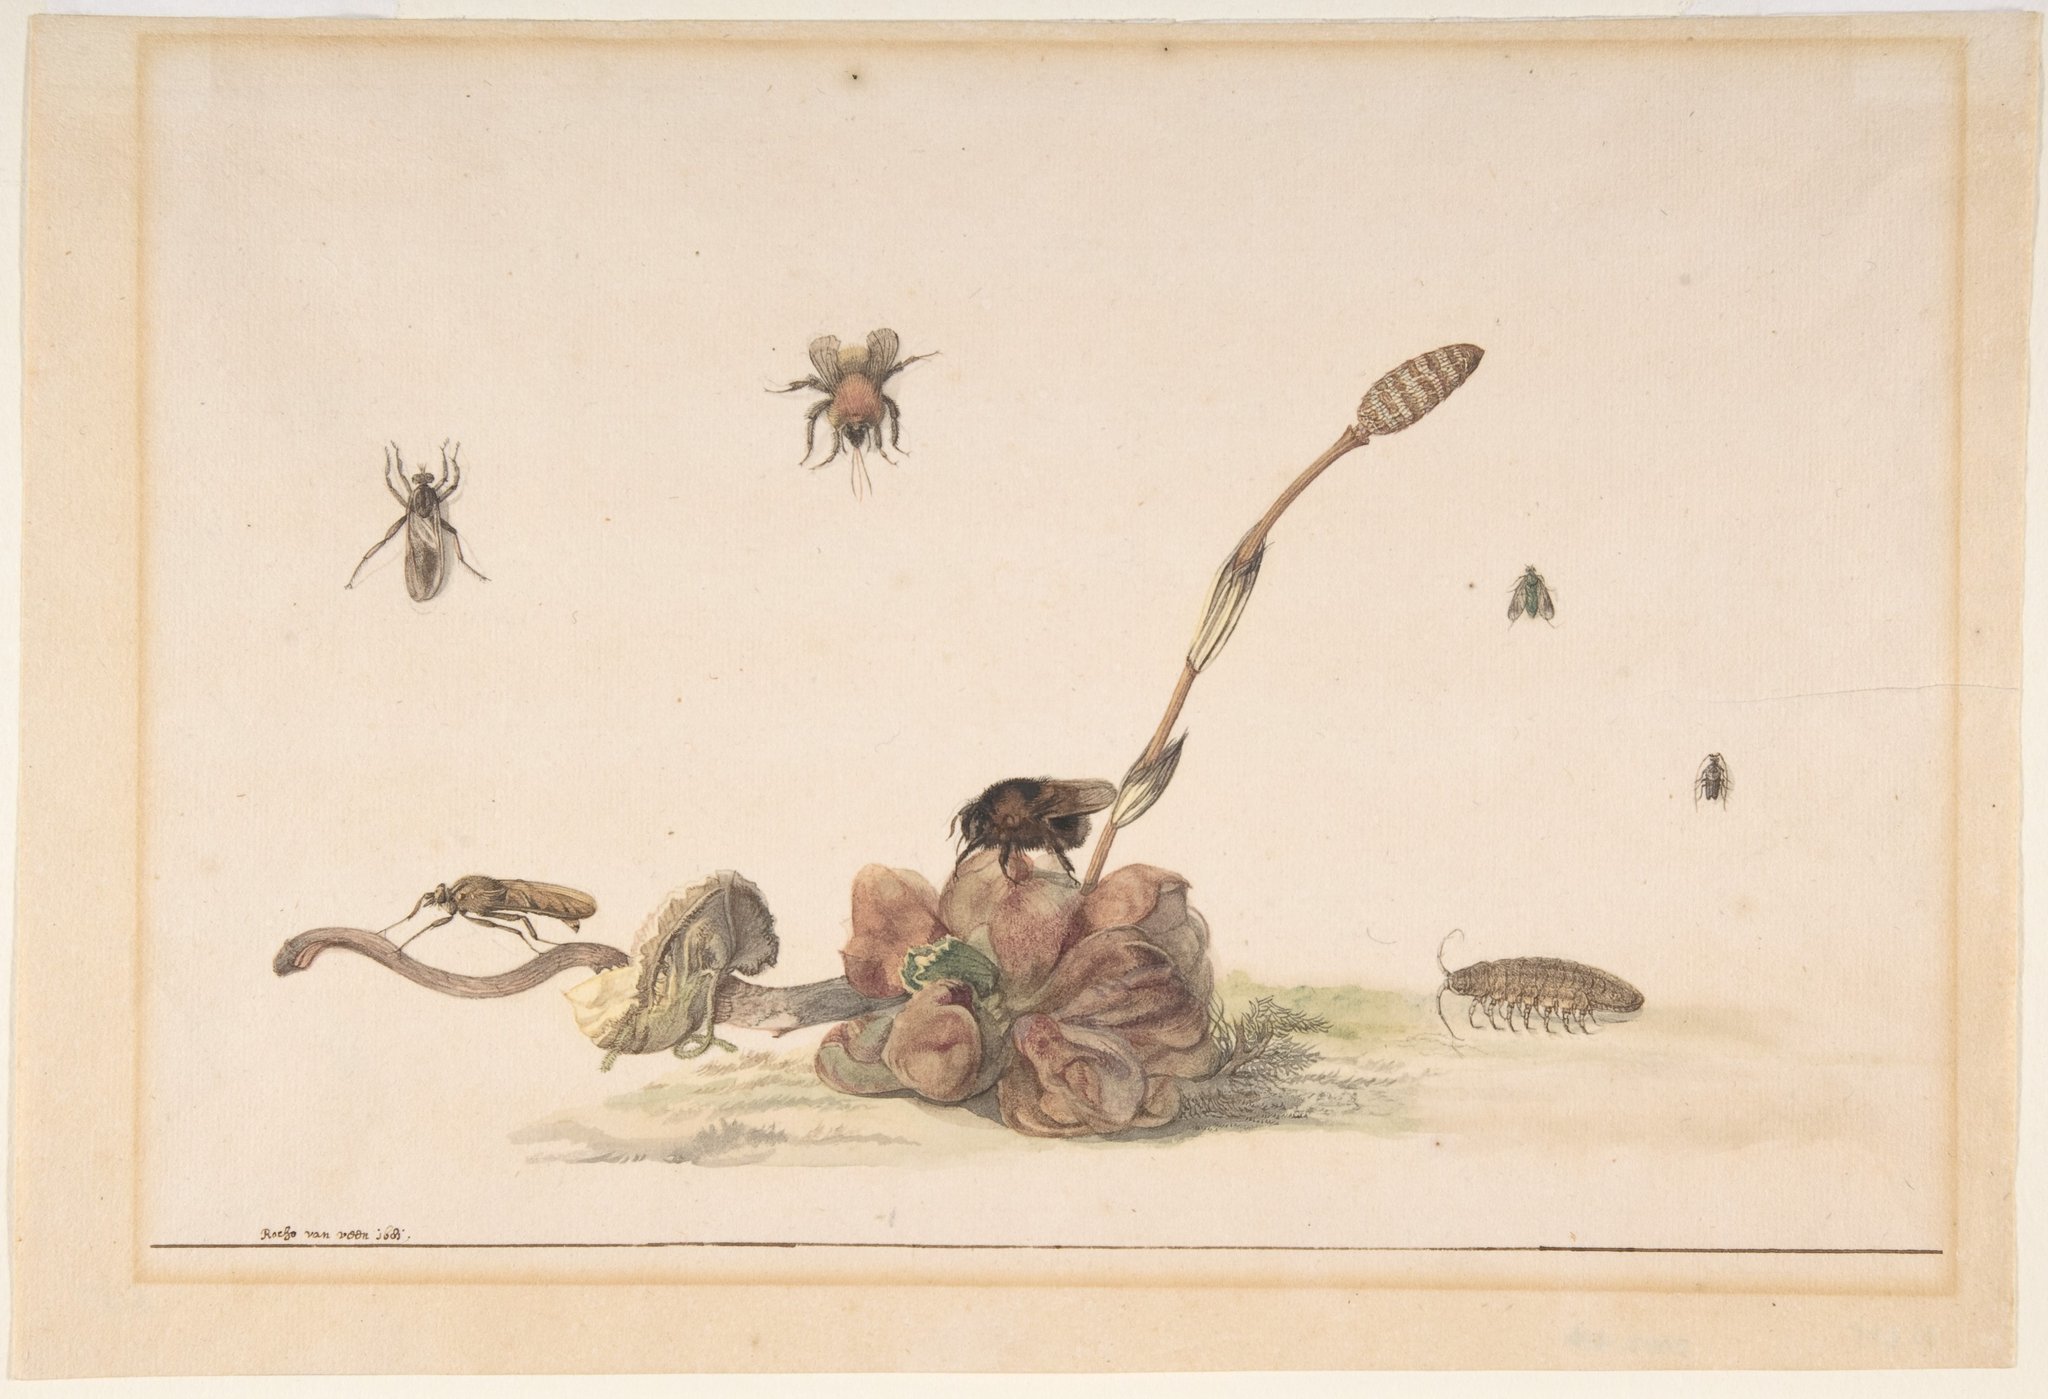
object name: drawing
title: Various Insects by a Fungus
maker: rochus van veen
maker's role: draughtsman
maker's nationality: dutch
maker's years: 1640-1693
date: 1681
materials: chalk, gouache, ink, watercolor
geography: germany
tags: insects